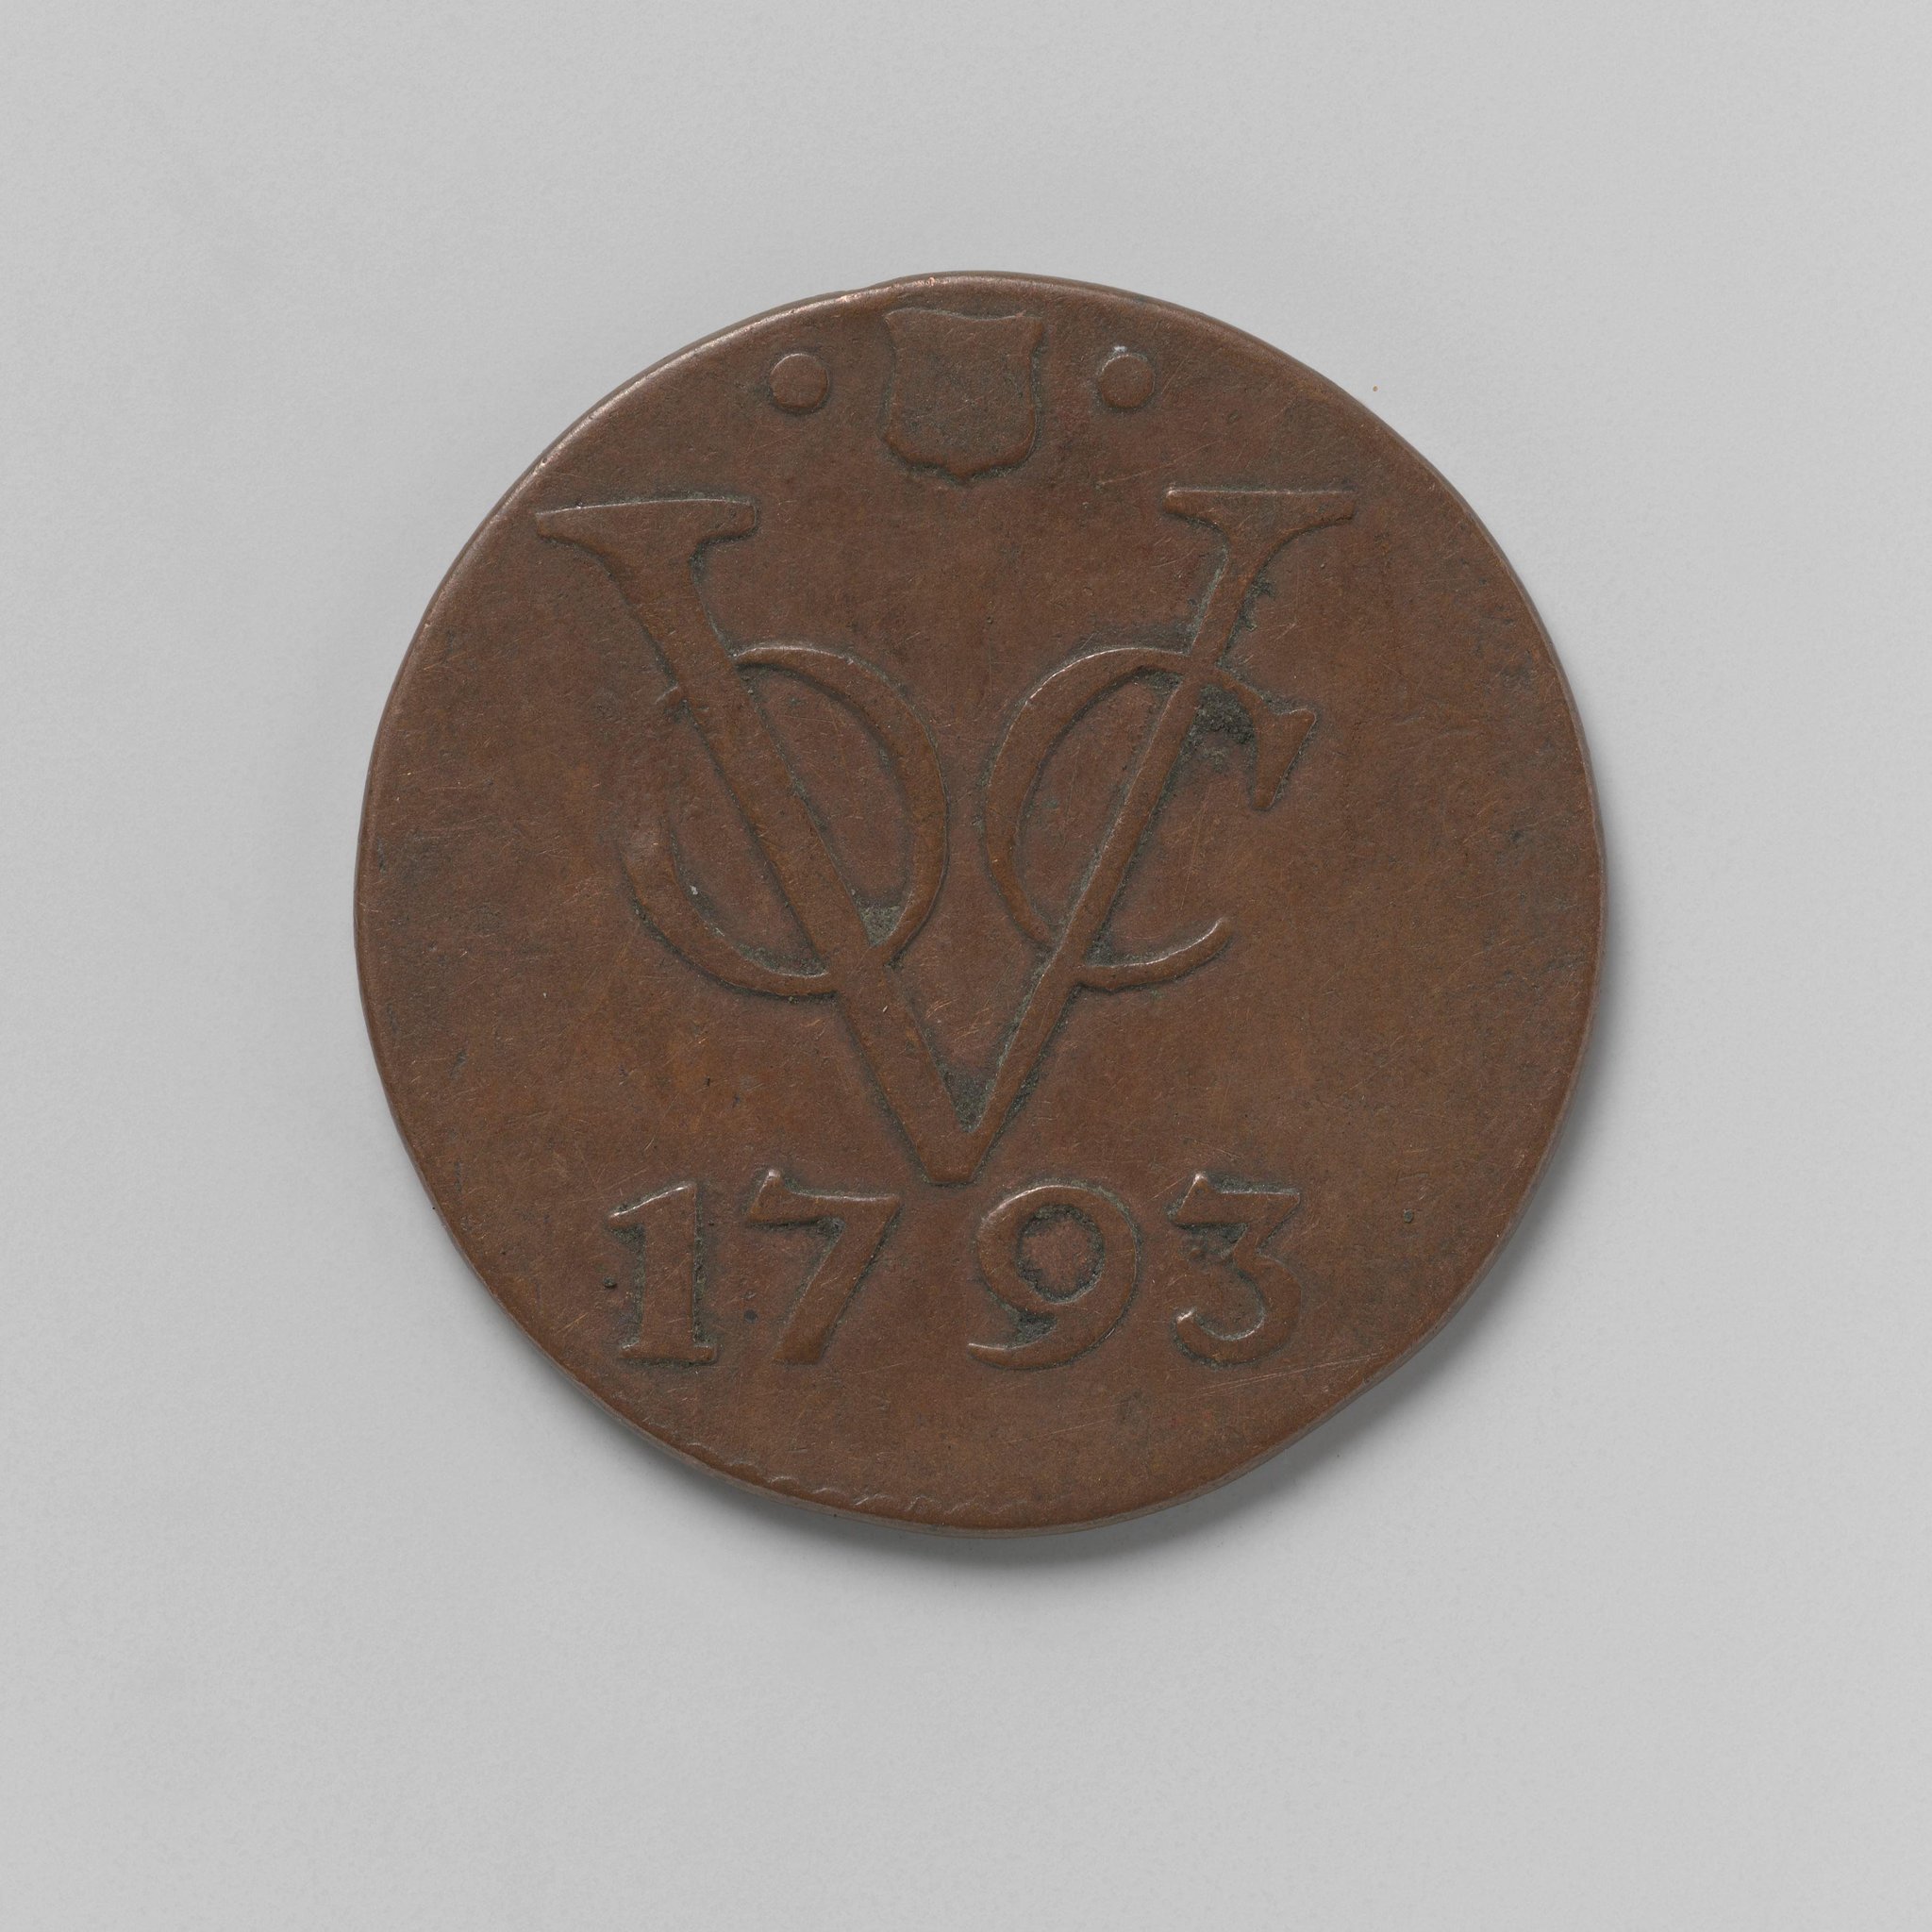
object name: coin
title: Duit van de VOC uit de stad Utrecht,1793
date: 1793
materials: copper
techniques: striking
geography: utrecht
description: Koperen munt. Voorzijde: op balk, waaronder guirlande, staand, door twee leeuwen gehouden gekroond wapenschild van de stad Utrecht. Keerzijde: monogram van de VOC, waarboven muntteken en waaronder jaartal. Gladde rand.